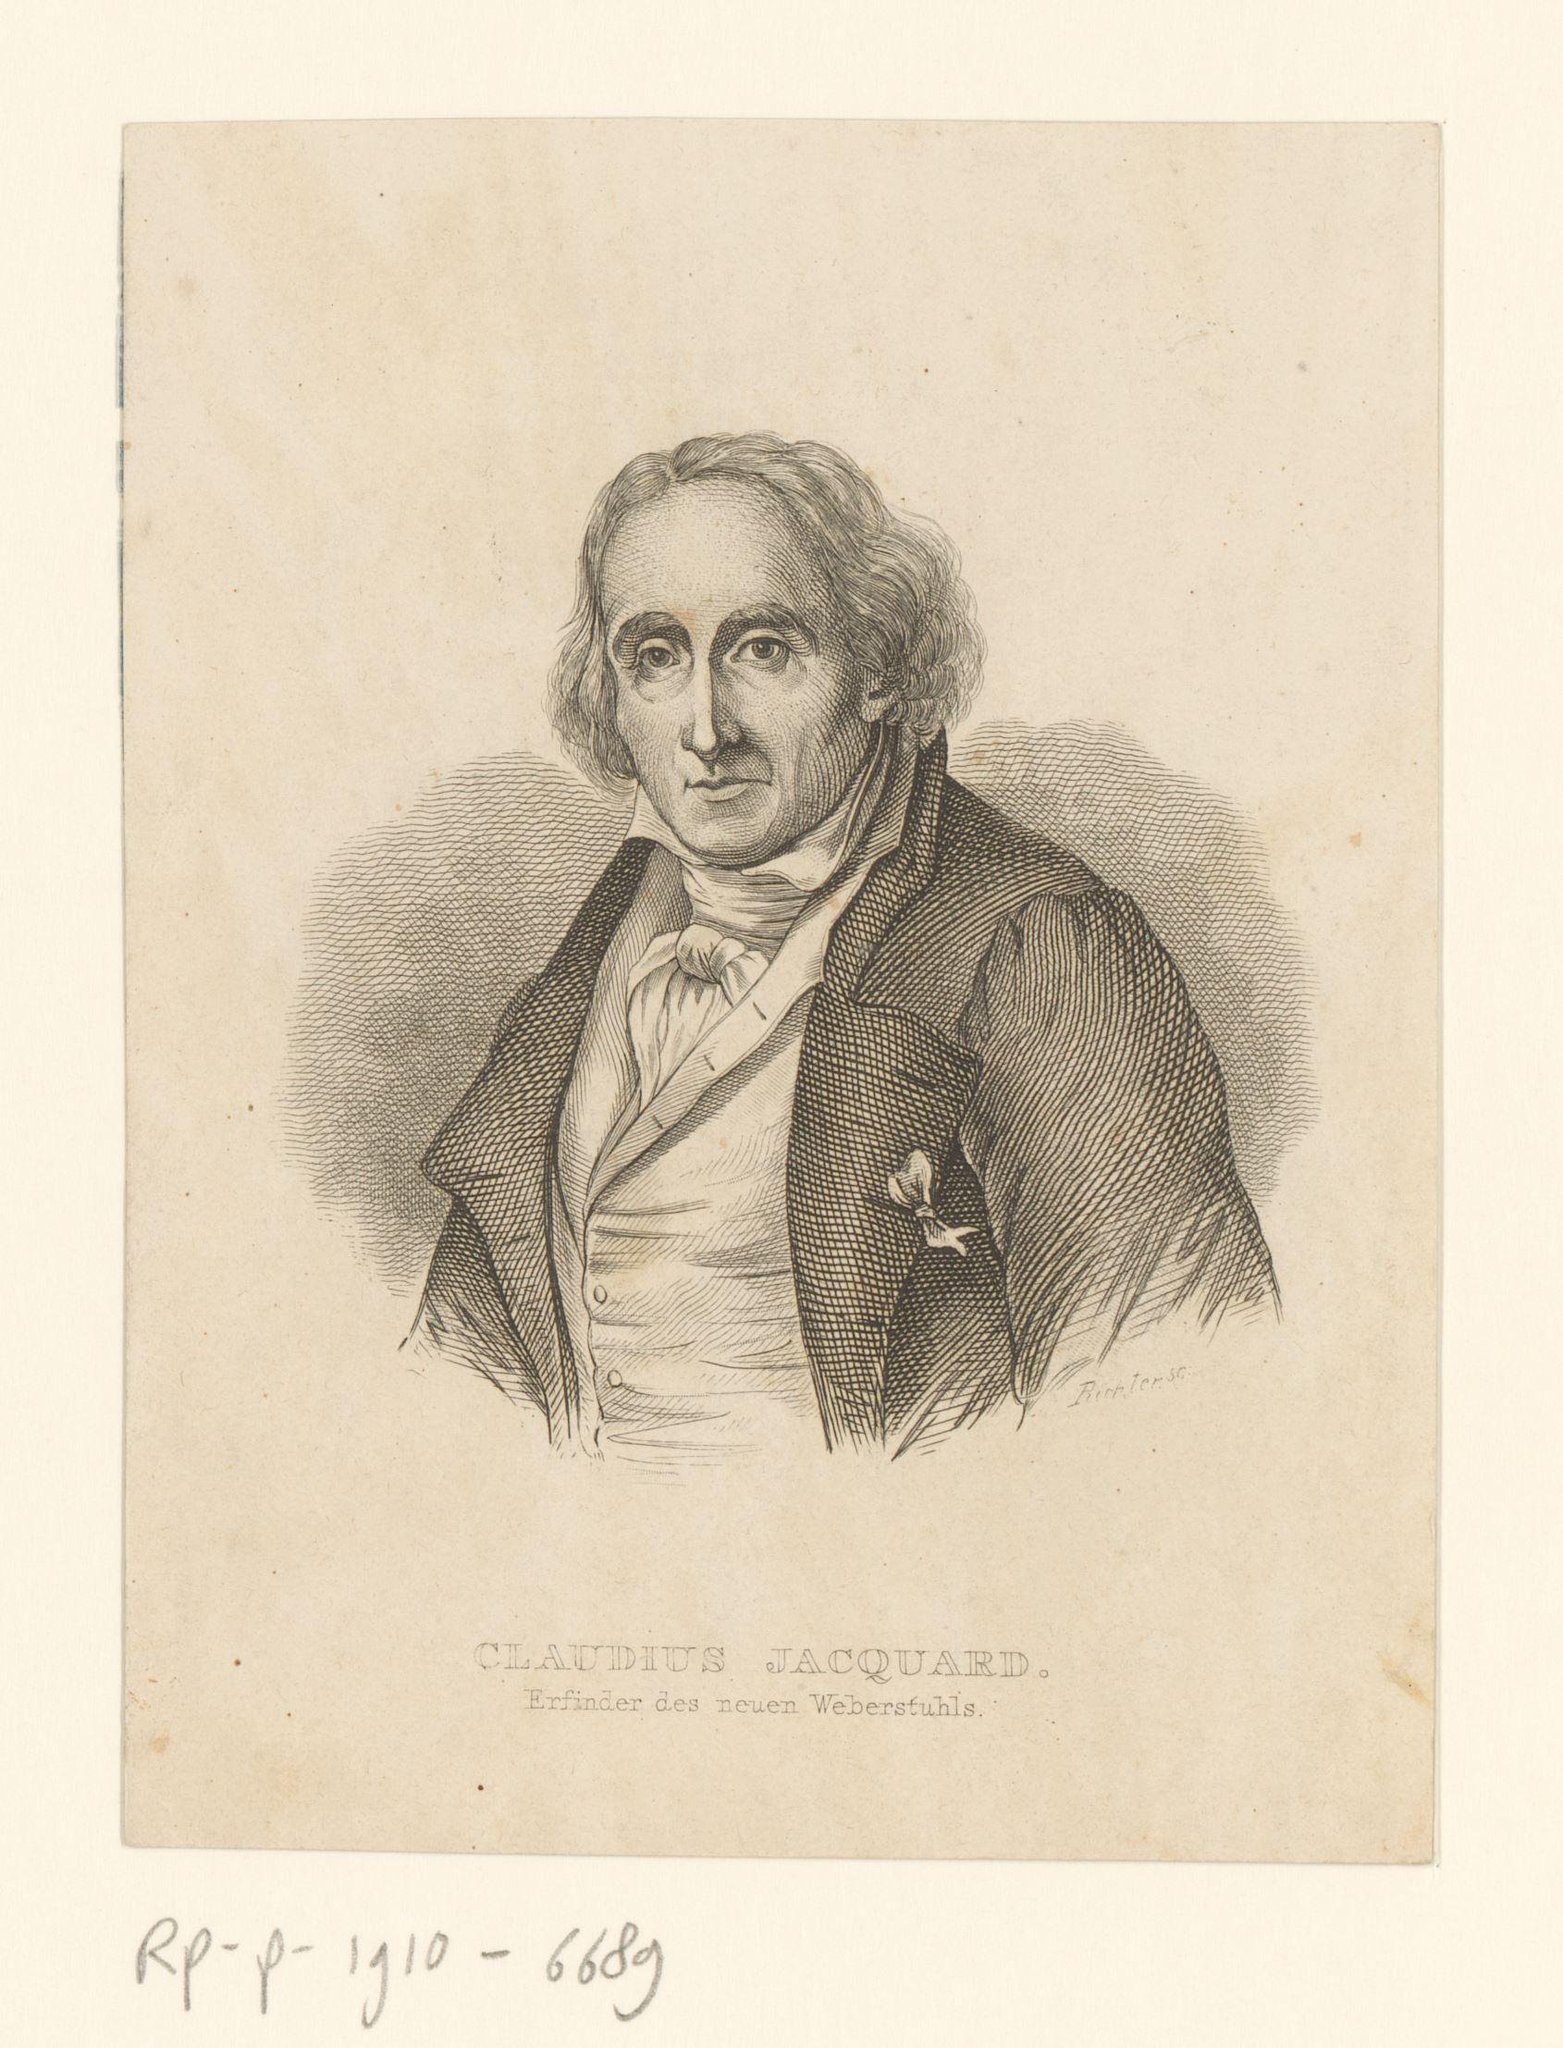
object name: print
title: Portret van Joseph Marie Jacquard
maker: f. richter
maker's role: print maker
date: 1800-1899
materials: paper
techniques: engraving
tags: joseph marie jacquard, historical persons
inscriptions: collector's mark: Lugt 2228